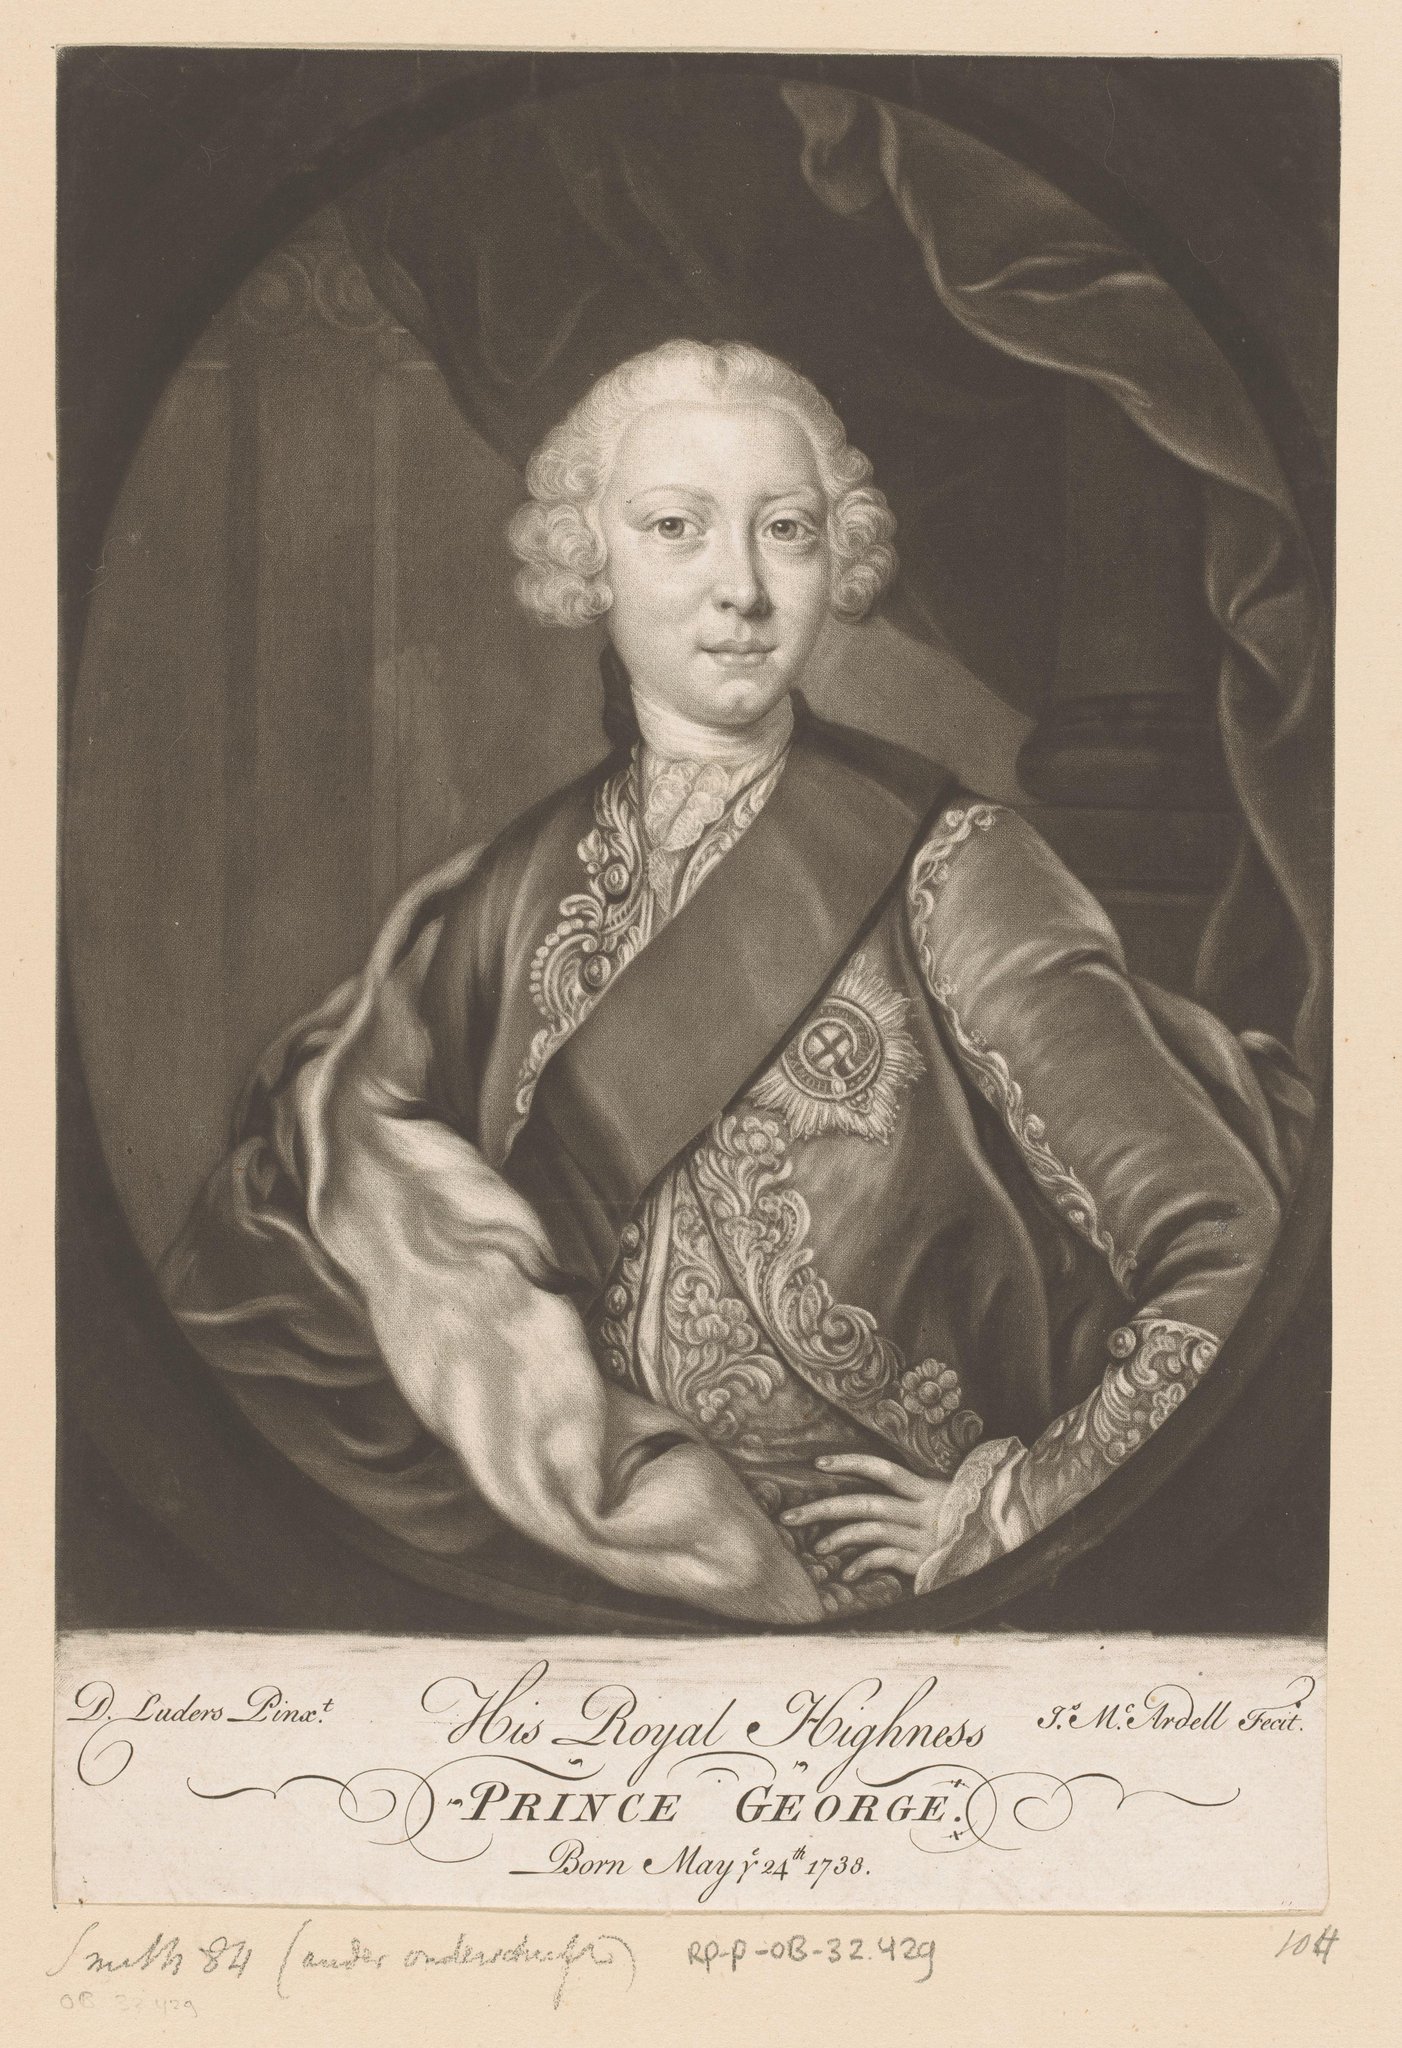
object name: print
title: His Royal Highness Prince George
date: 1751-1756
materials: paper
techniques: mezzotint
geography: london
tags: london, george iii (koning van het verenigd koninkrijk), historical persons, crown prince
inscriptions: collector's mark: Lugt 240